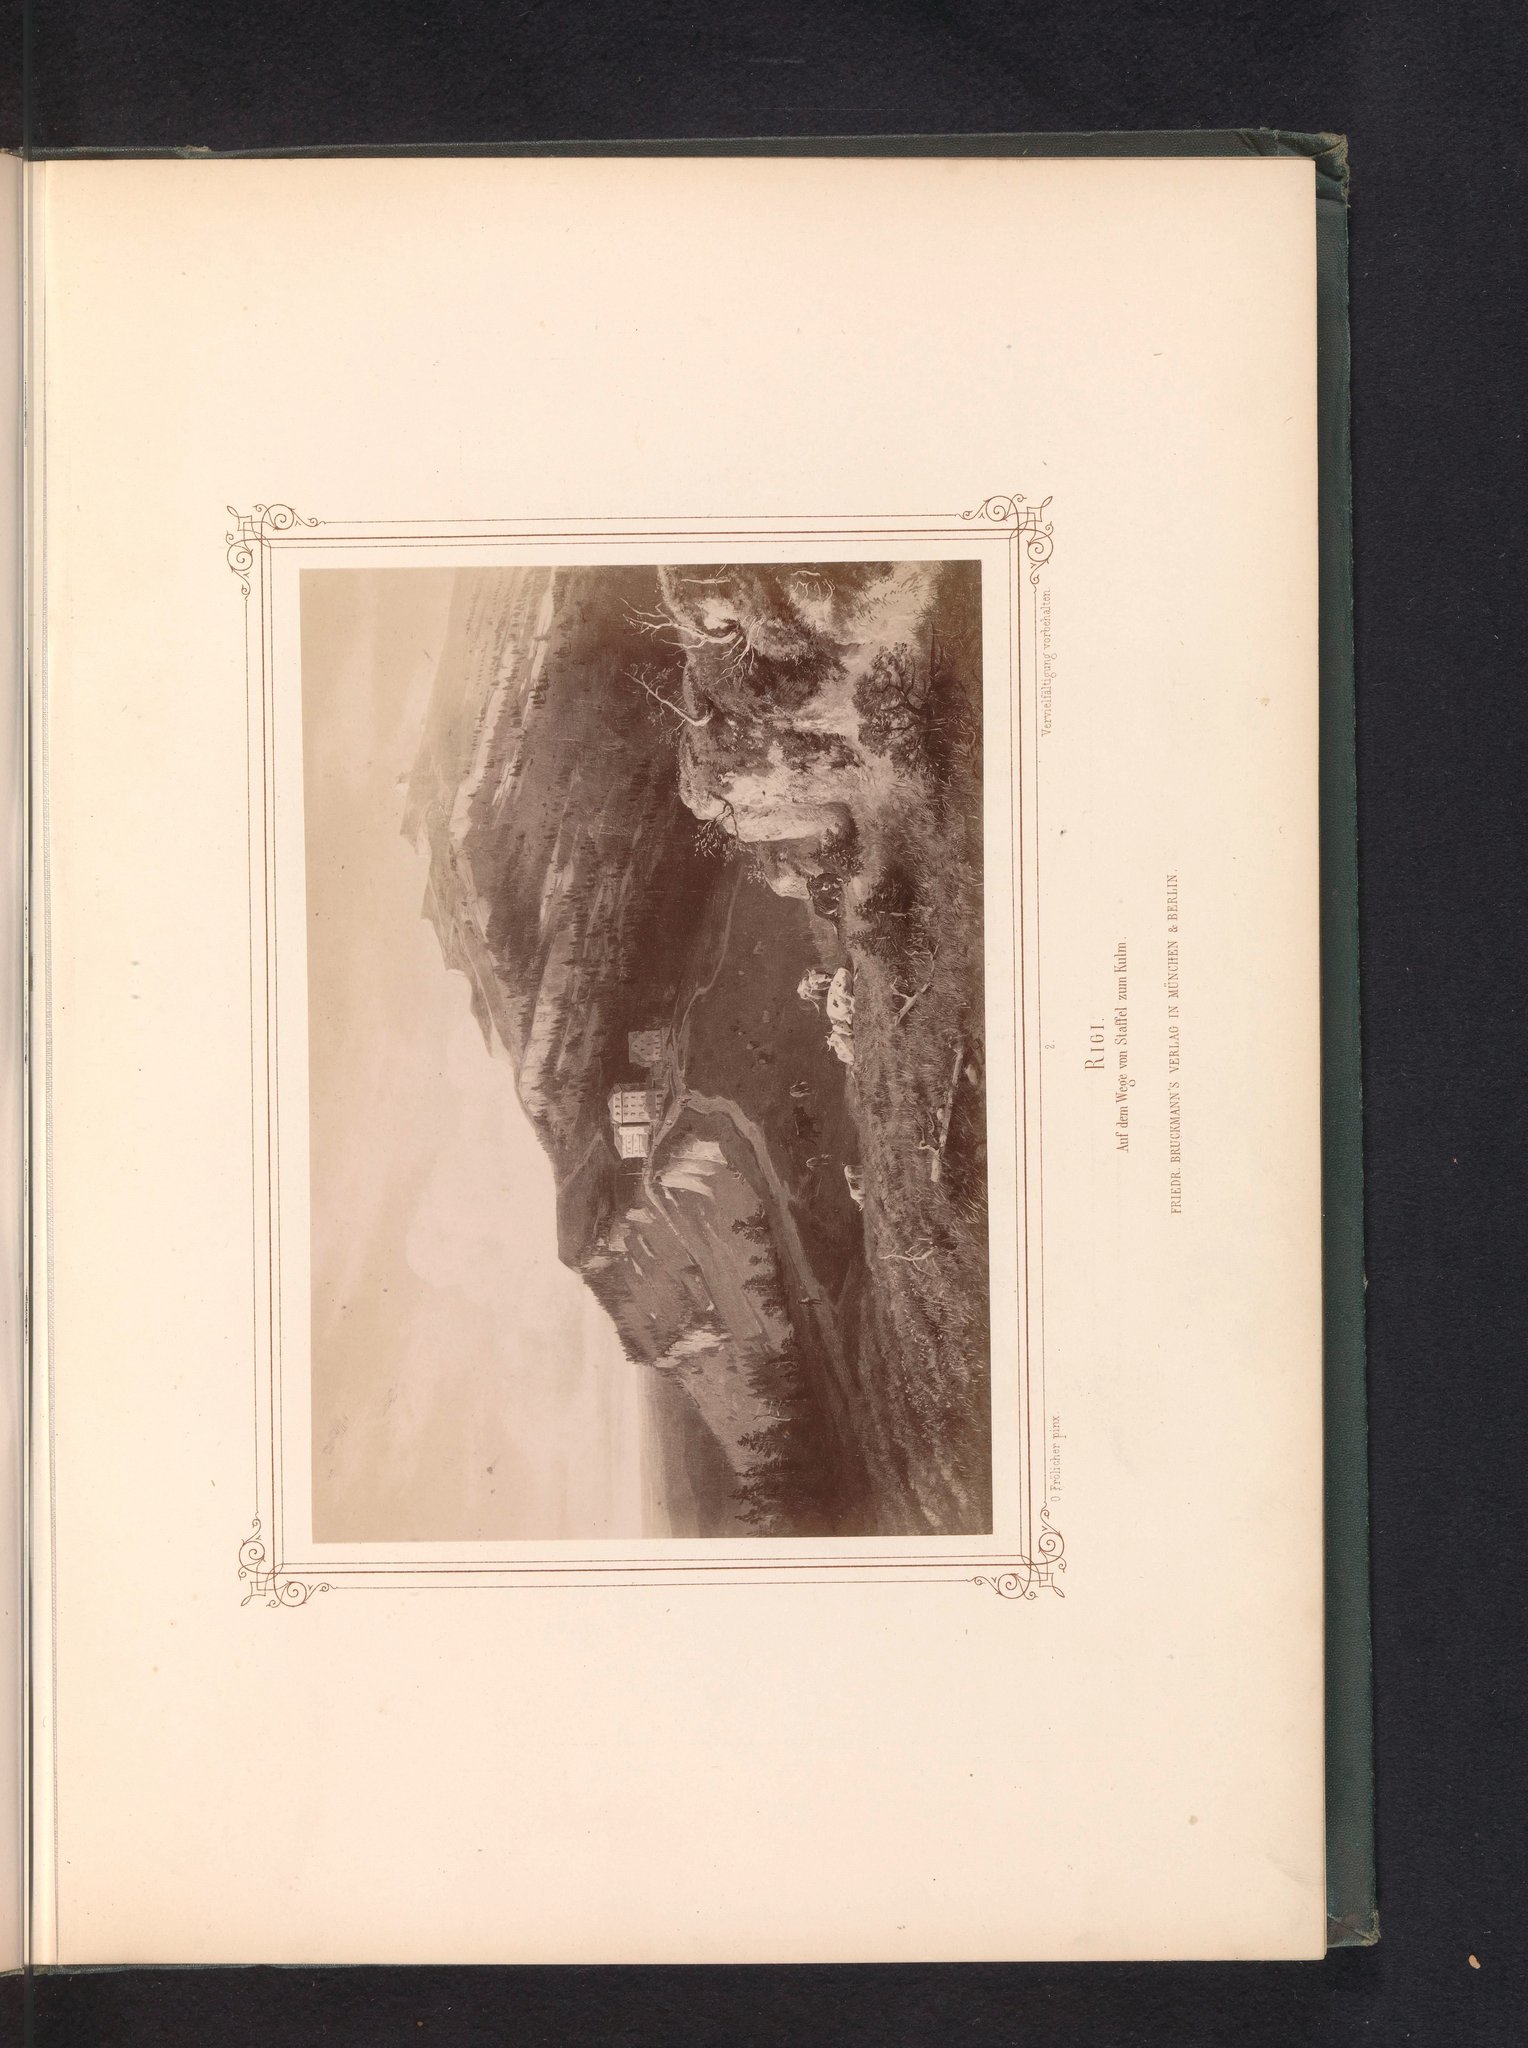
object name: reproduction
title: Fotoreproductie van een schilderij van de berg Rigi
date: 1863-1873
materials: photographic support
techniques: albumen print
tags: mountains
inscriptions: number: ‘2.’